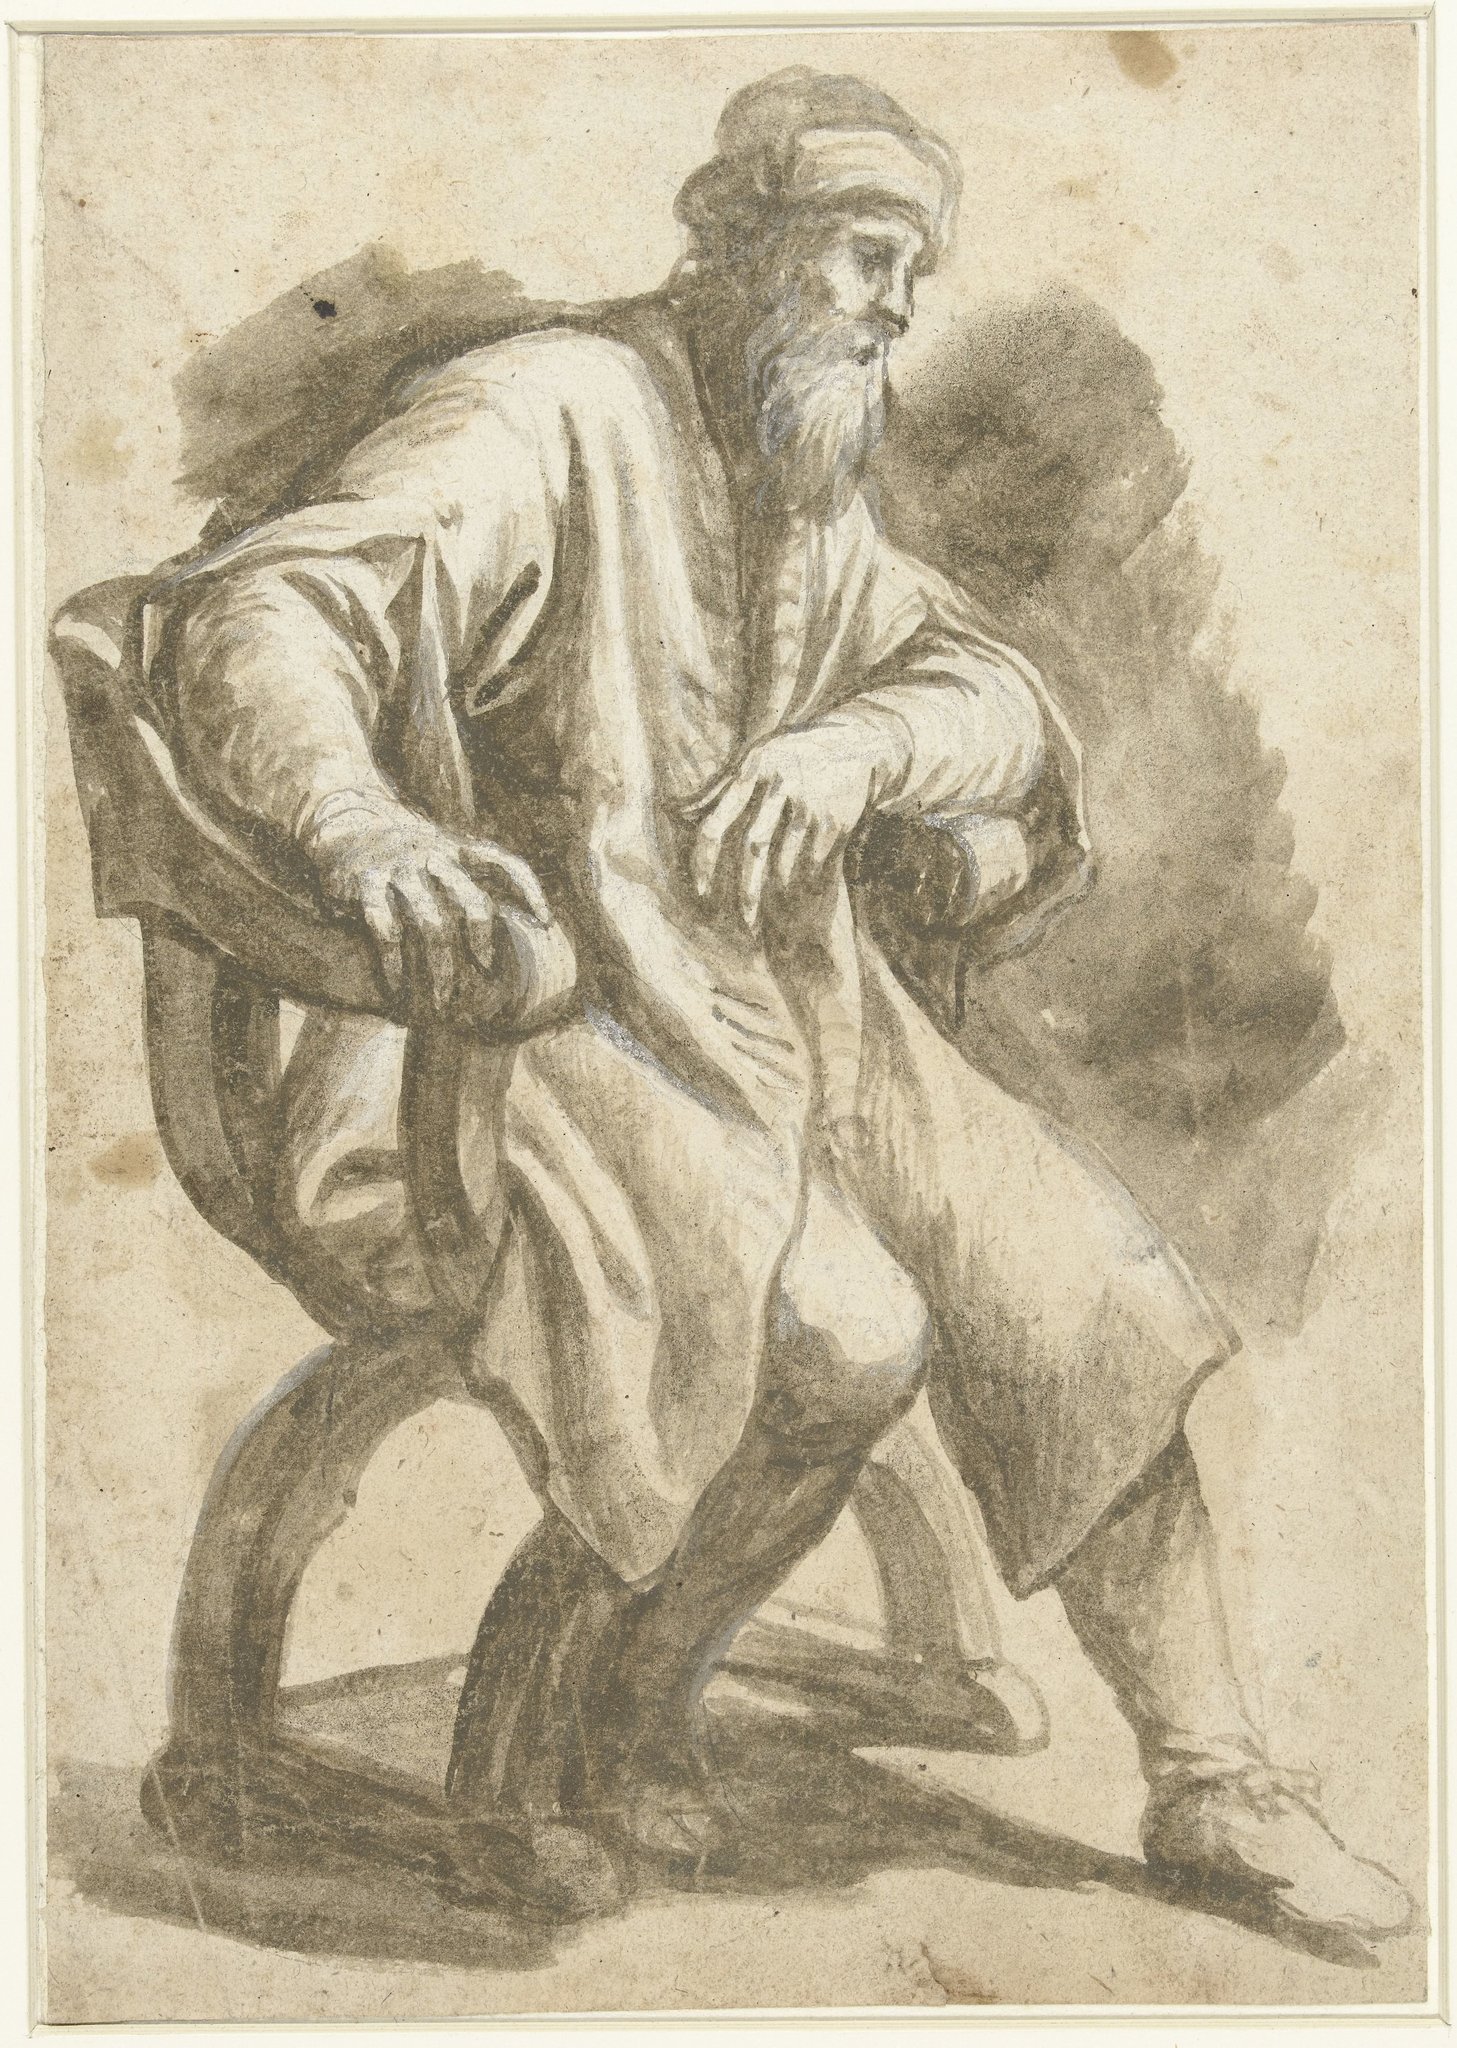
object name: drawing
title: Man in leunstoel gezeten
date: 1580-1620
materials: paper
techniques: brush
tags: armchair, seat, sitting figure